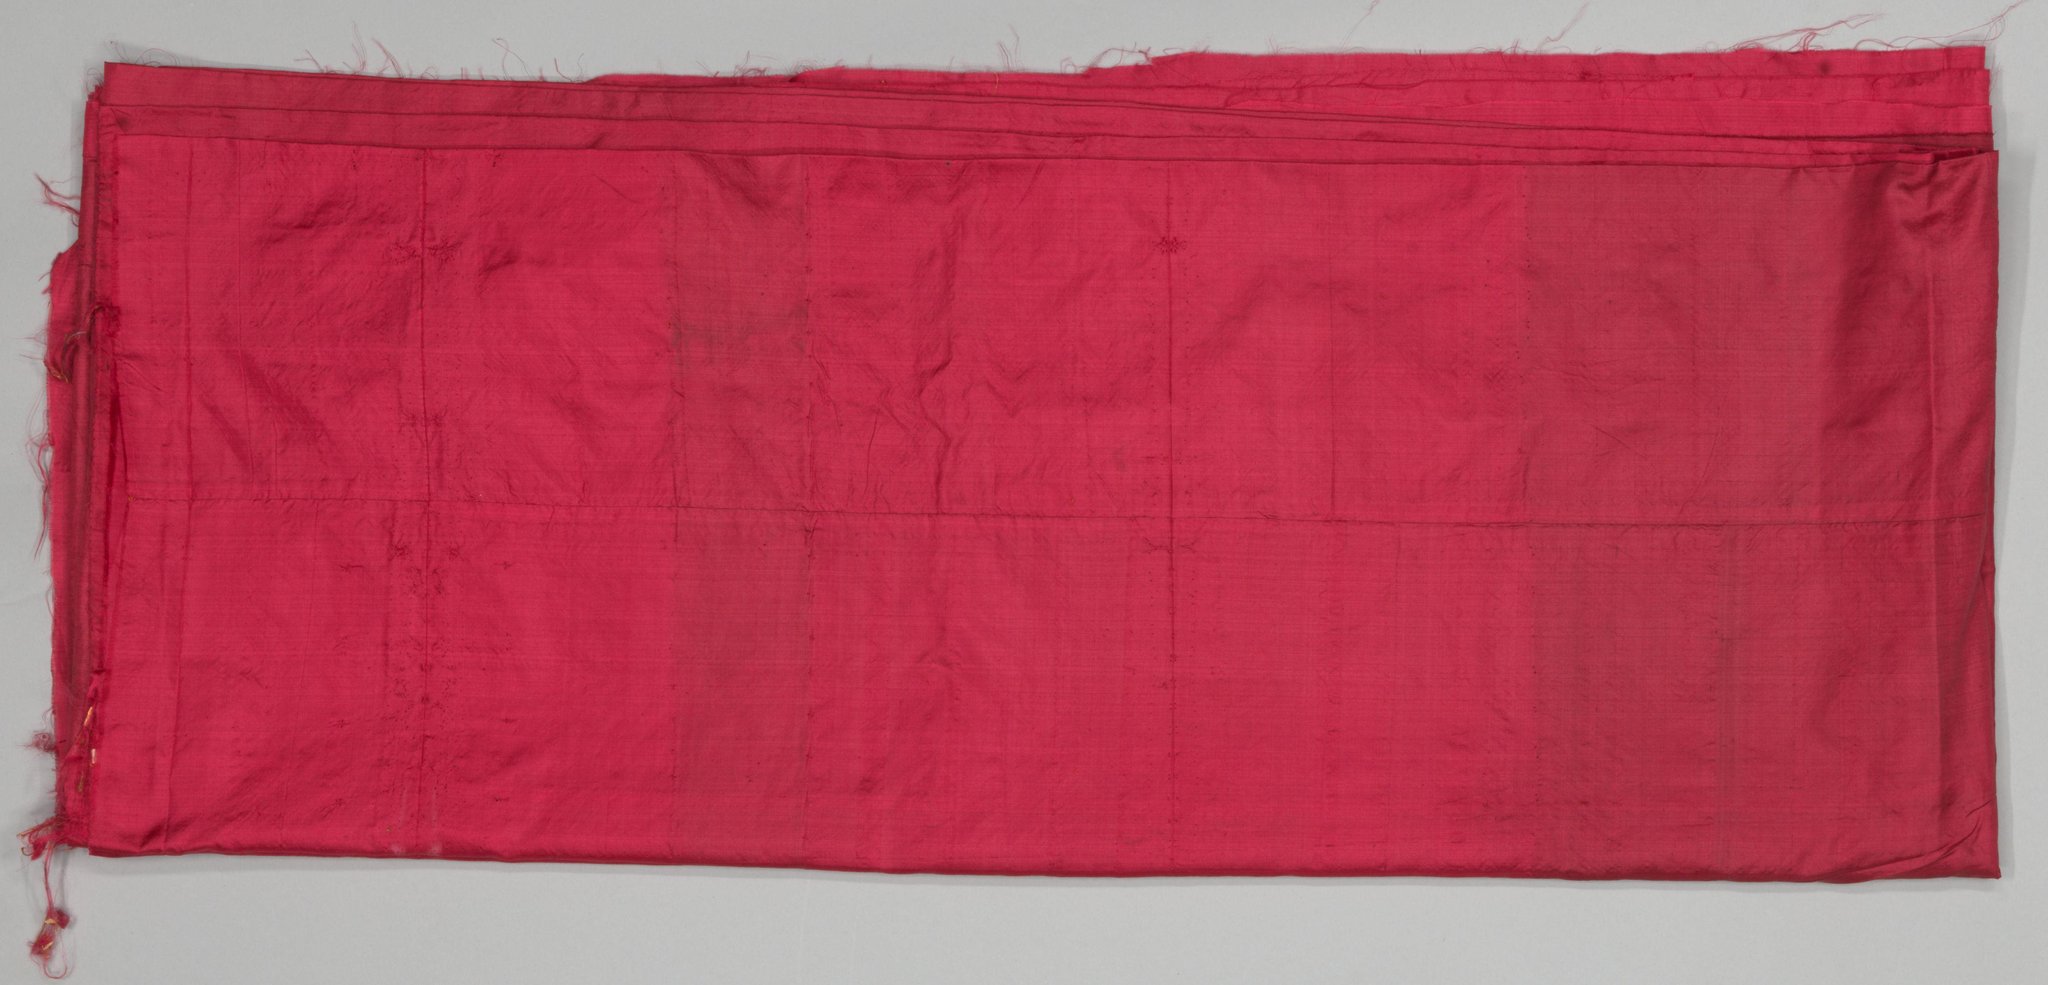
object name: liner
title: Voering van rode zijde, behorend bij een gordijn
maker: Anonymous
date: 1830-1870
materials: silk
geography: france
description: Voering van rode zijde, behorend bij een gordijn (zie A en B).